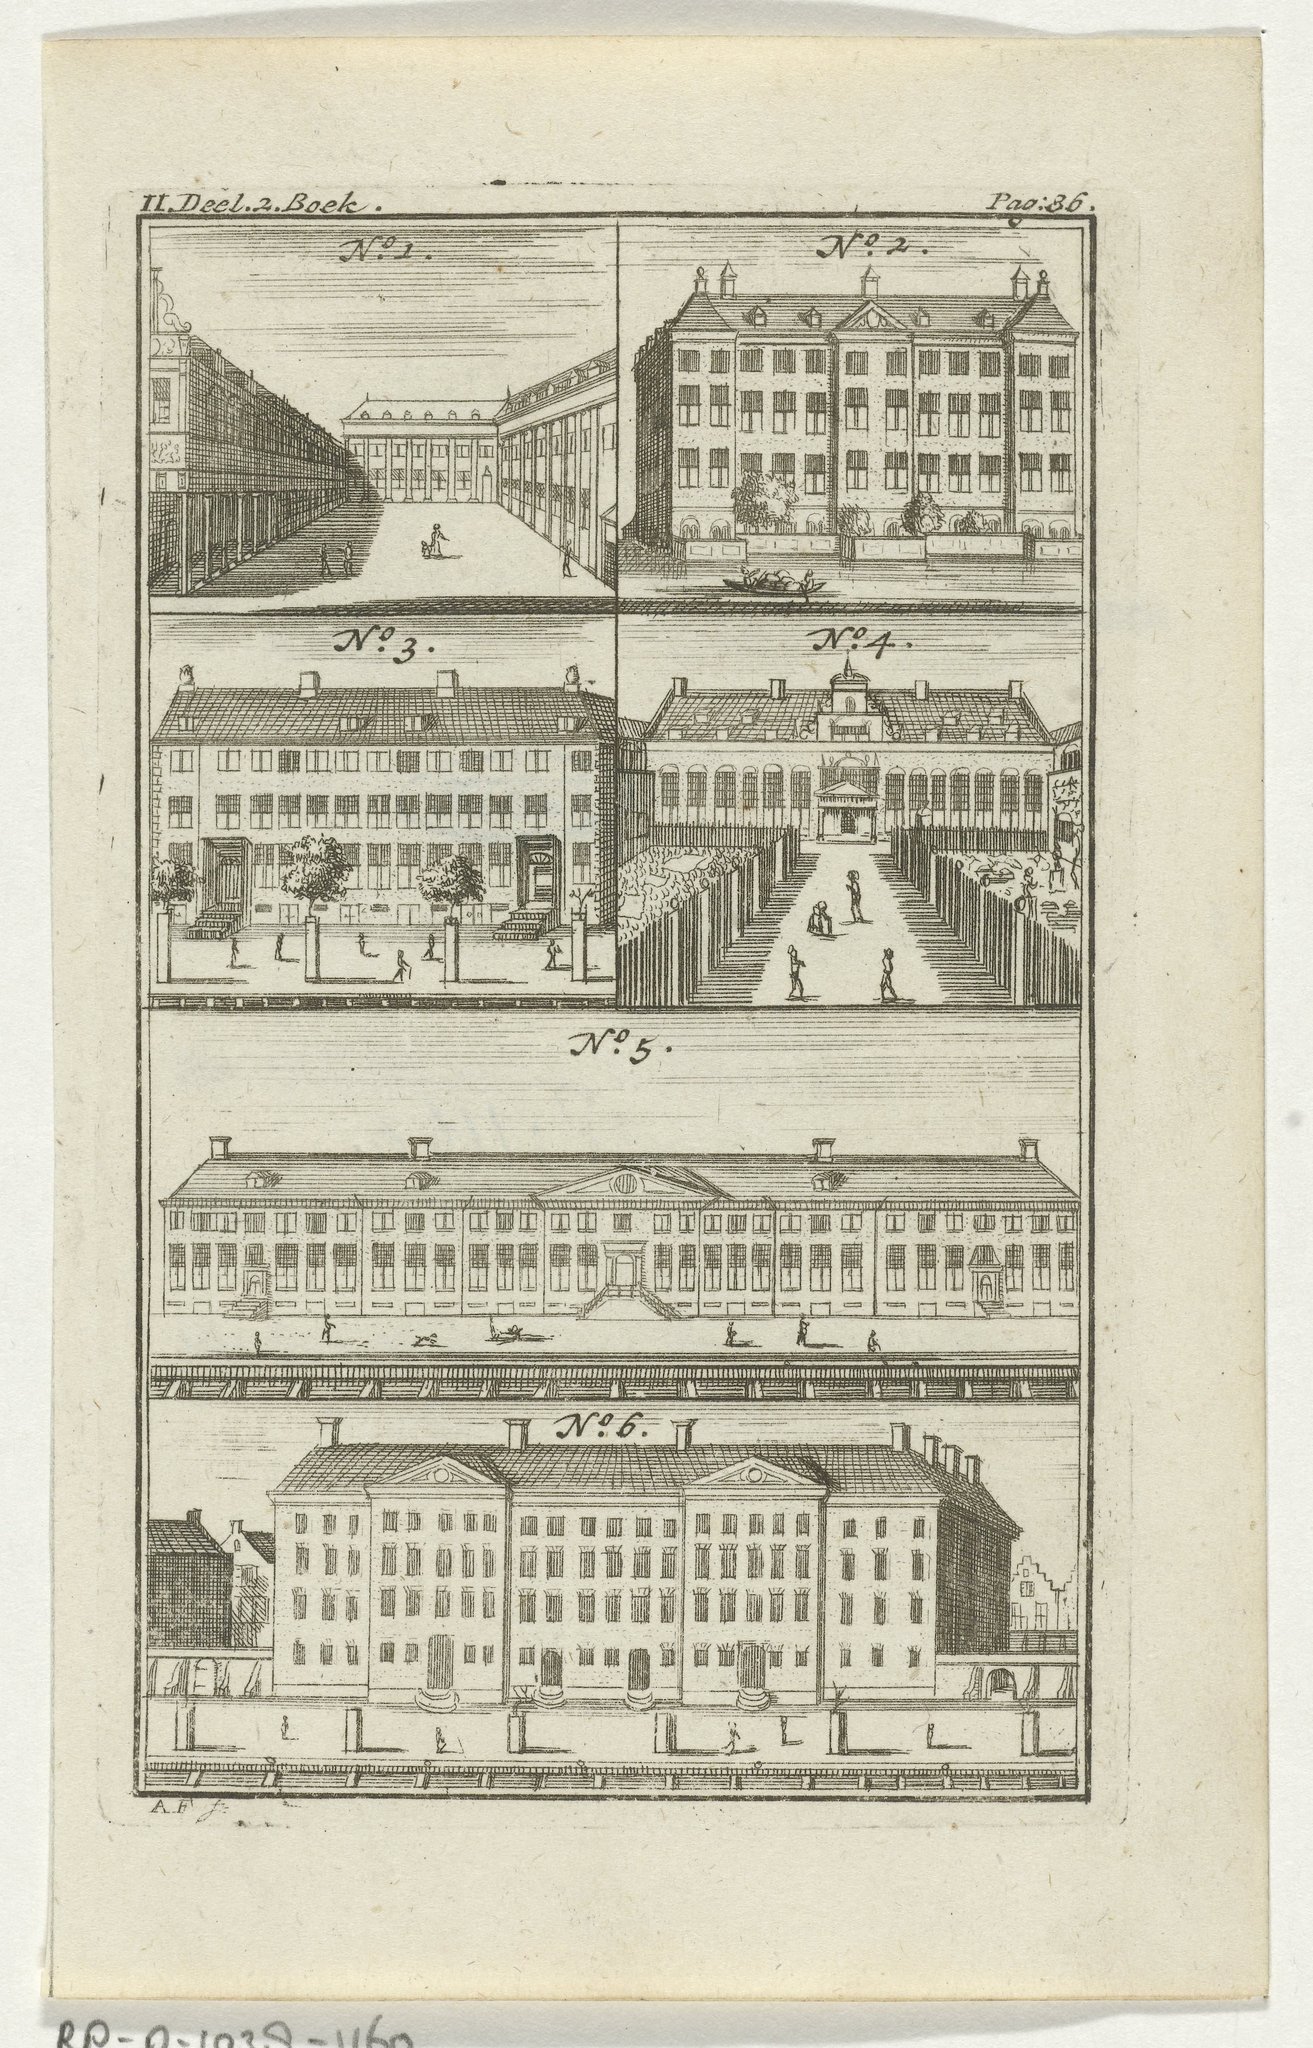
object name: print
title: Zes verschillende gebouwen te Amsterdam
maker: anna folkema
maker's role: draughtsman, print maker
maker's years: 1695-1768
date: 1723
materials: paper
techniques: etching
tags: civic architecture; edifices; dwellings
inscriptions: collector's mark: Lugt 2760, collector's mark: Lugt 2228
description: Zes genummerde gebouwen te Amsterdam: Burgerweeshuis, Diaconieweeshuis, Walenweeshuis, Lutherse Diaconiehuis, Besjeshuis en Aalmoezeniersweeshuis. De gebouwen zijn op het bijbehorende tekstblad voorzien van toelichting. Prent links- en rechtsboven gemerkt: II. Deel. 2. Boek - Pag: 36.